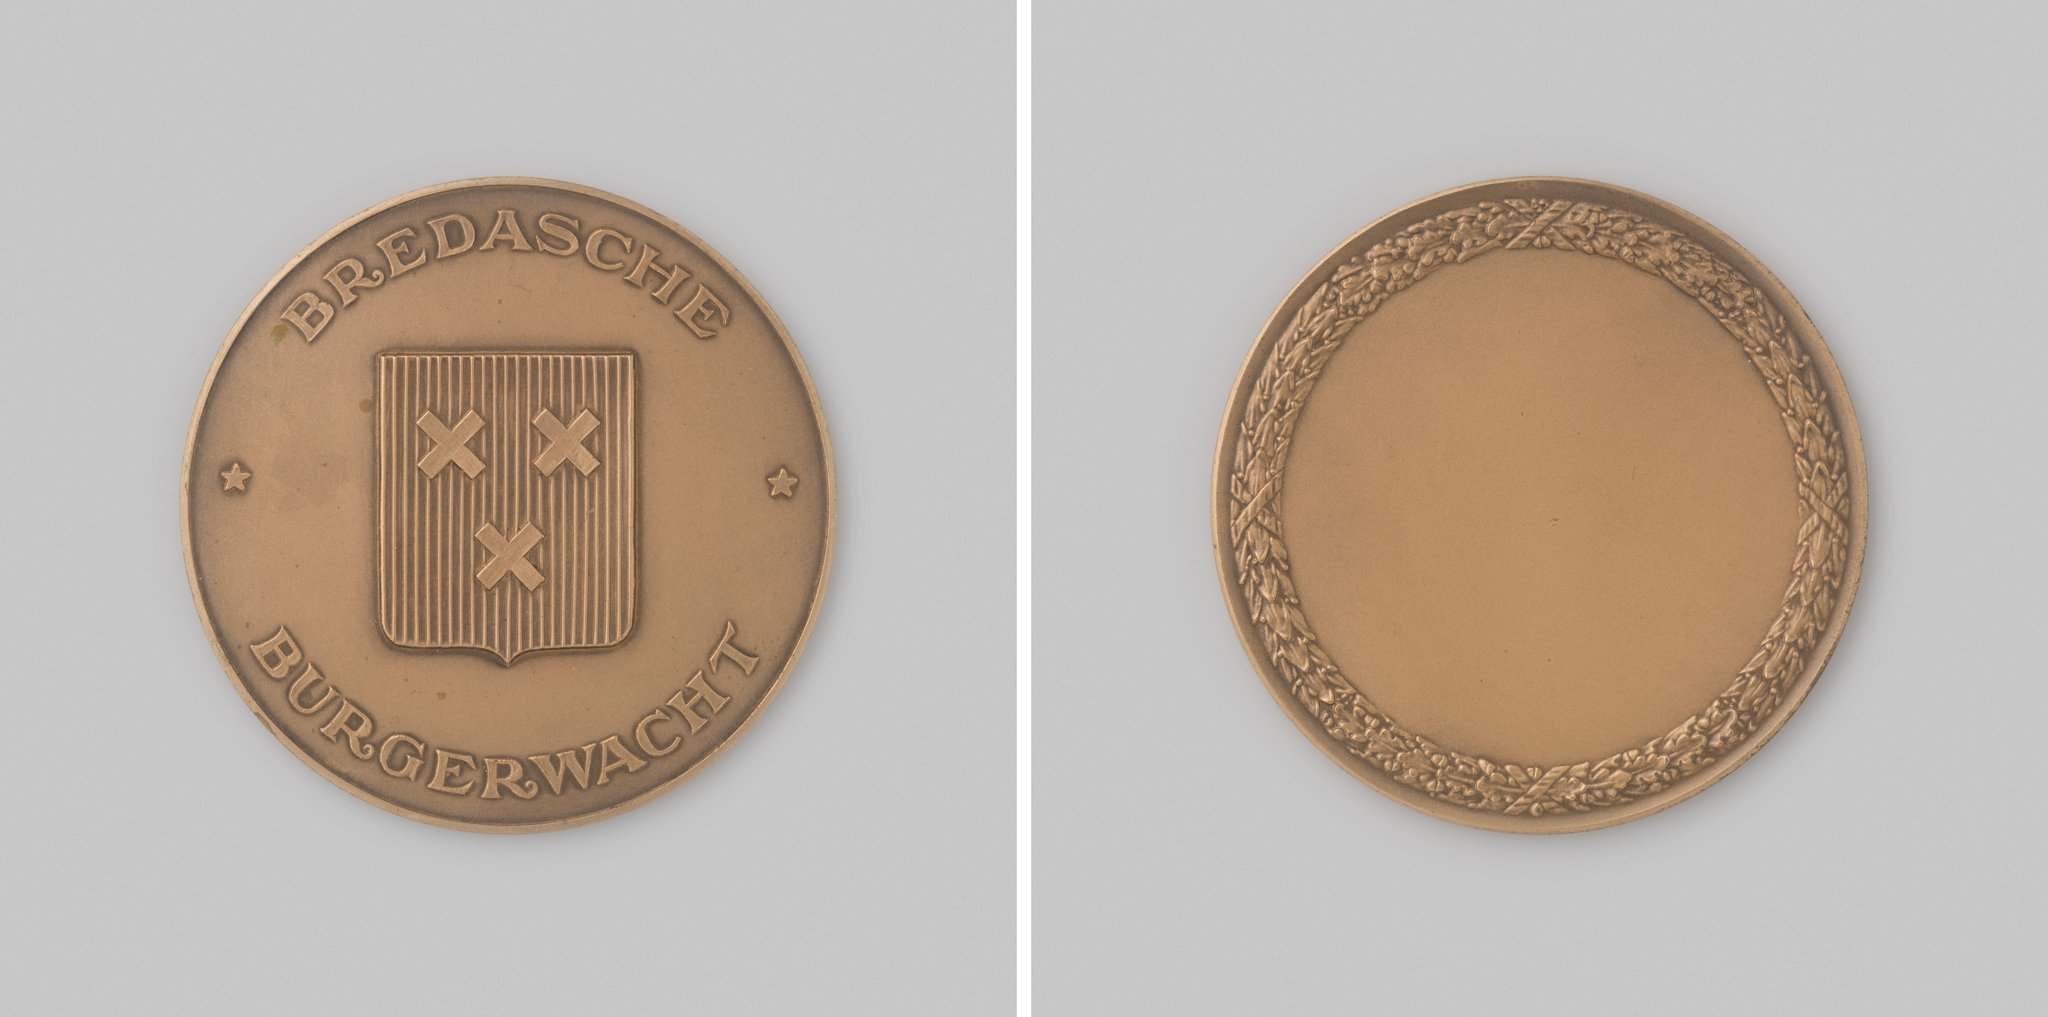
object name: marksman medal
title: Penning van de Bredasche Burgerwacht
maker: Anonymous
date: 1800-1910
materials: metal